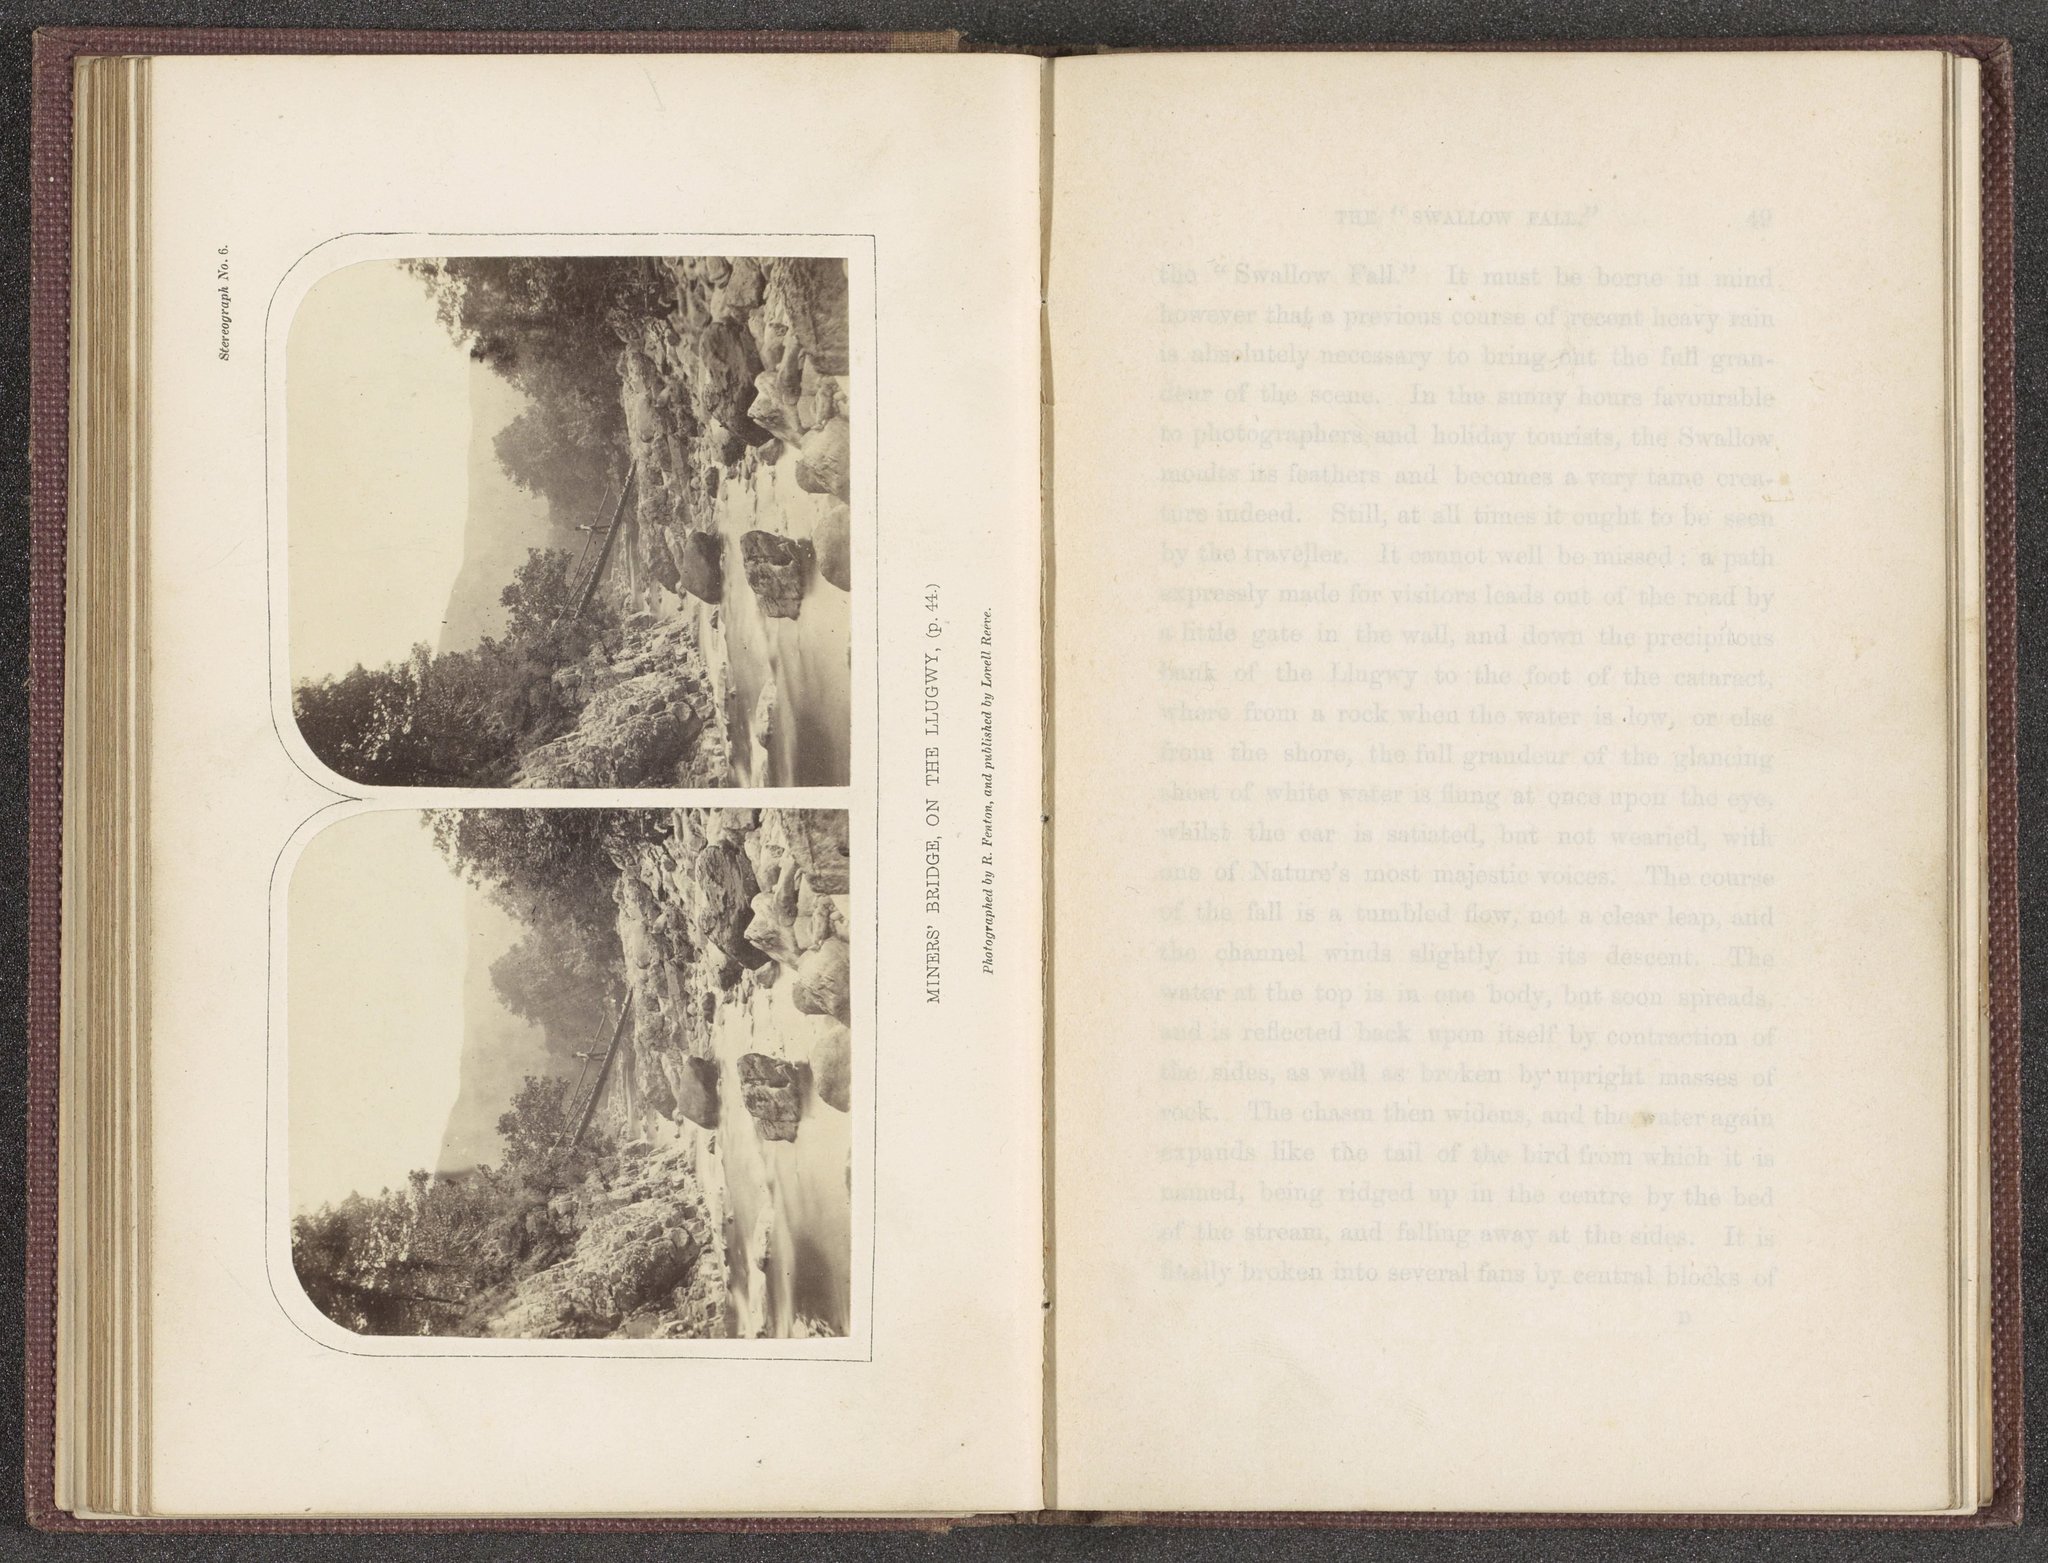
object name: page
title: Miners' bridge on the Llugwy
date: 1859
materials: paper, photographic support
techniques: albumen print, printing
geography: wales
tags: river, bridge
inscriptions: number: ‘Stereograph No. 6.’